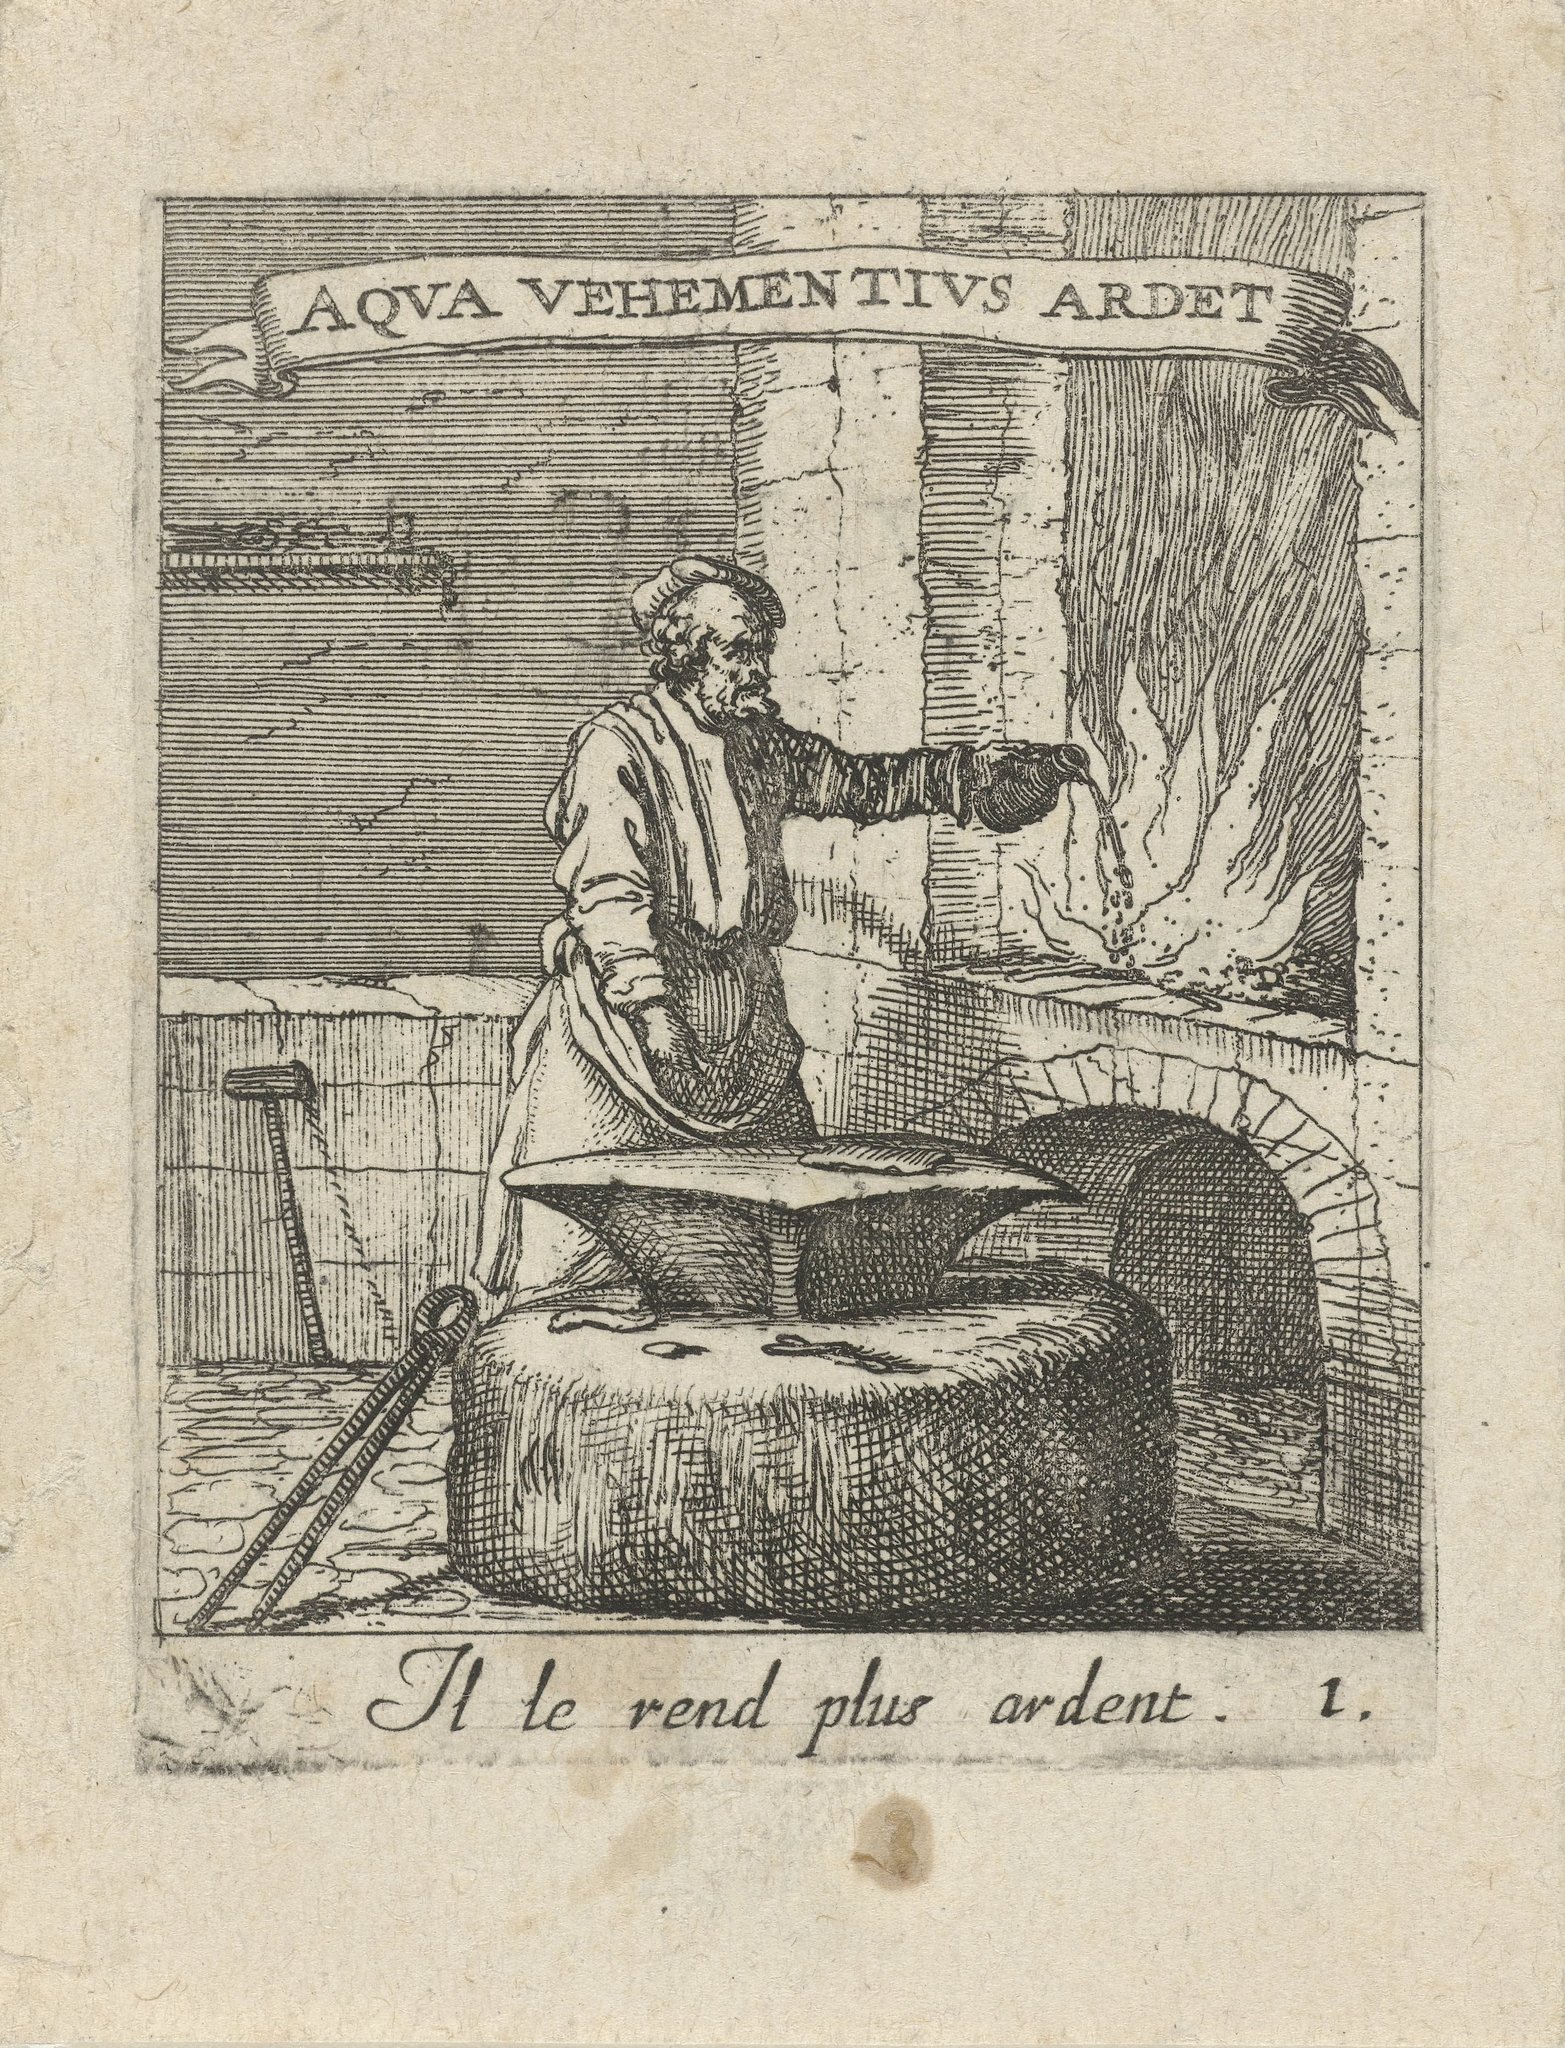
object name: print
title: Smid bij een vuur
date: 1672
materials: paper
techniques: etching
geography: paris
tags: qualities of love: first series (+ emblematical representation of concept)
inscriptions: collector's mark: Lugt 2166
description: Een smid gooit water op het vuur in de smederij. Op een banderol een devies in Latijn en een onderschrift in Frans, beide over de liefde. Op de achterkant de Franse serietitel.